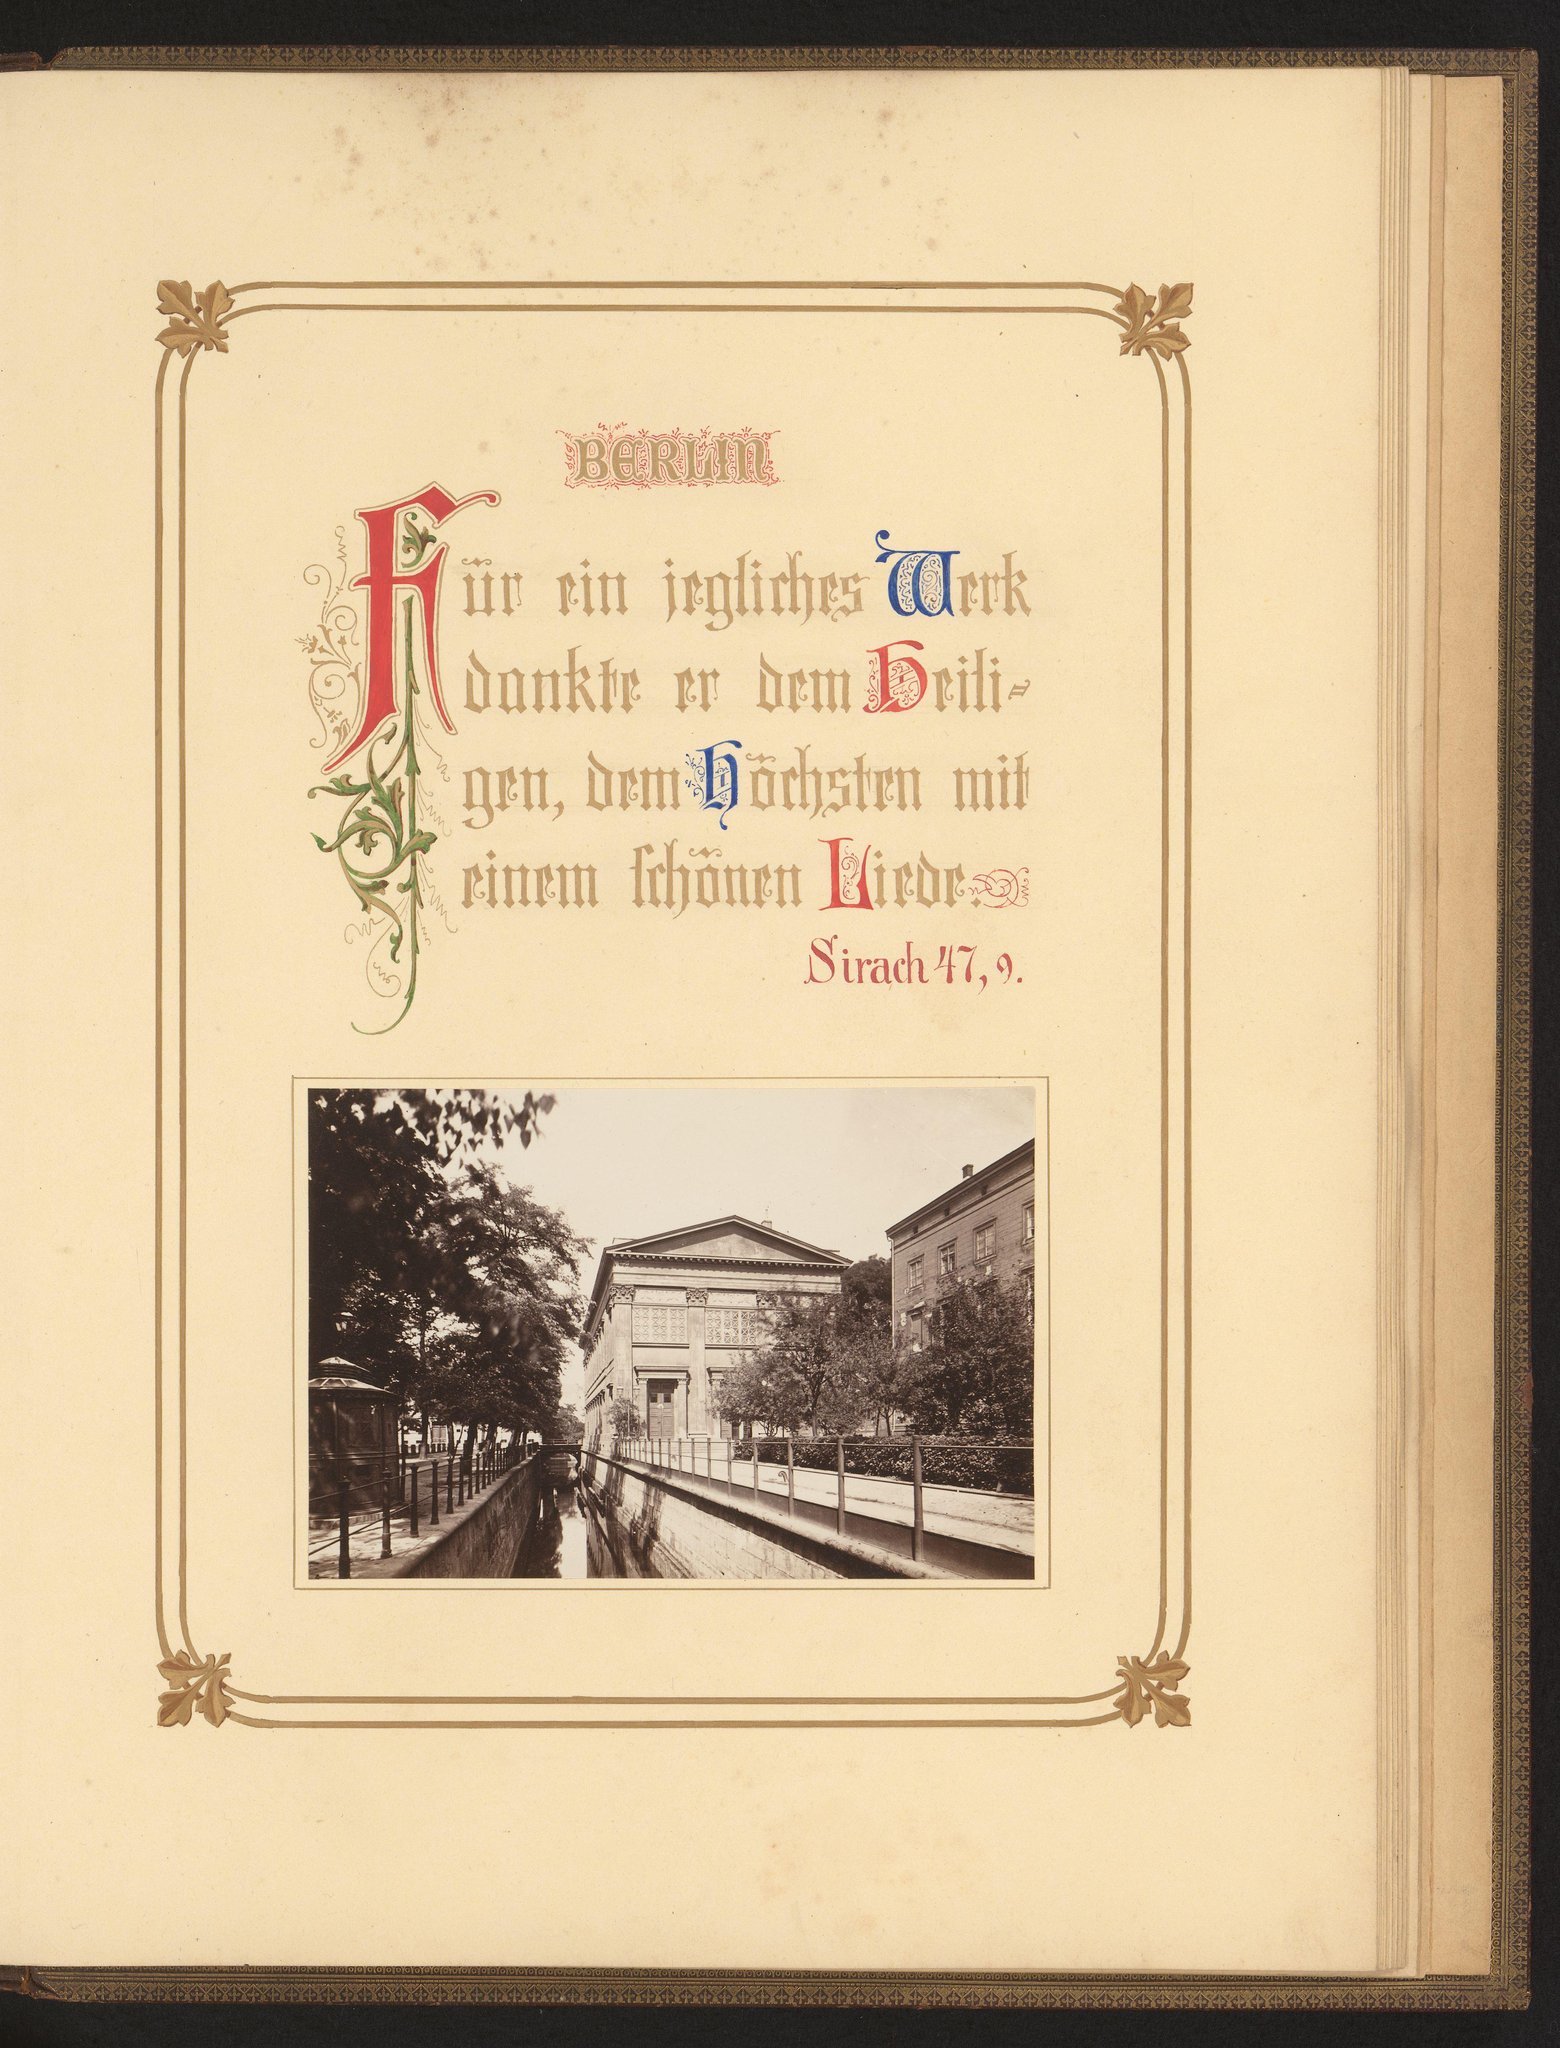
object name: album leaf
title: Berlin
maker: Anonymous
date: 1873-1875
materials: paper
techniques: albumen print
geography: berlin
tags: choir, concert hall, berlin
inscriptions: inscription: ‘Für ein jegliches Werk/ dankte er dem Heili-/ gen, dem Höchsten mit/ einem schönen Liebe./ Sirach 47,9.’